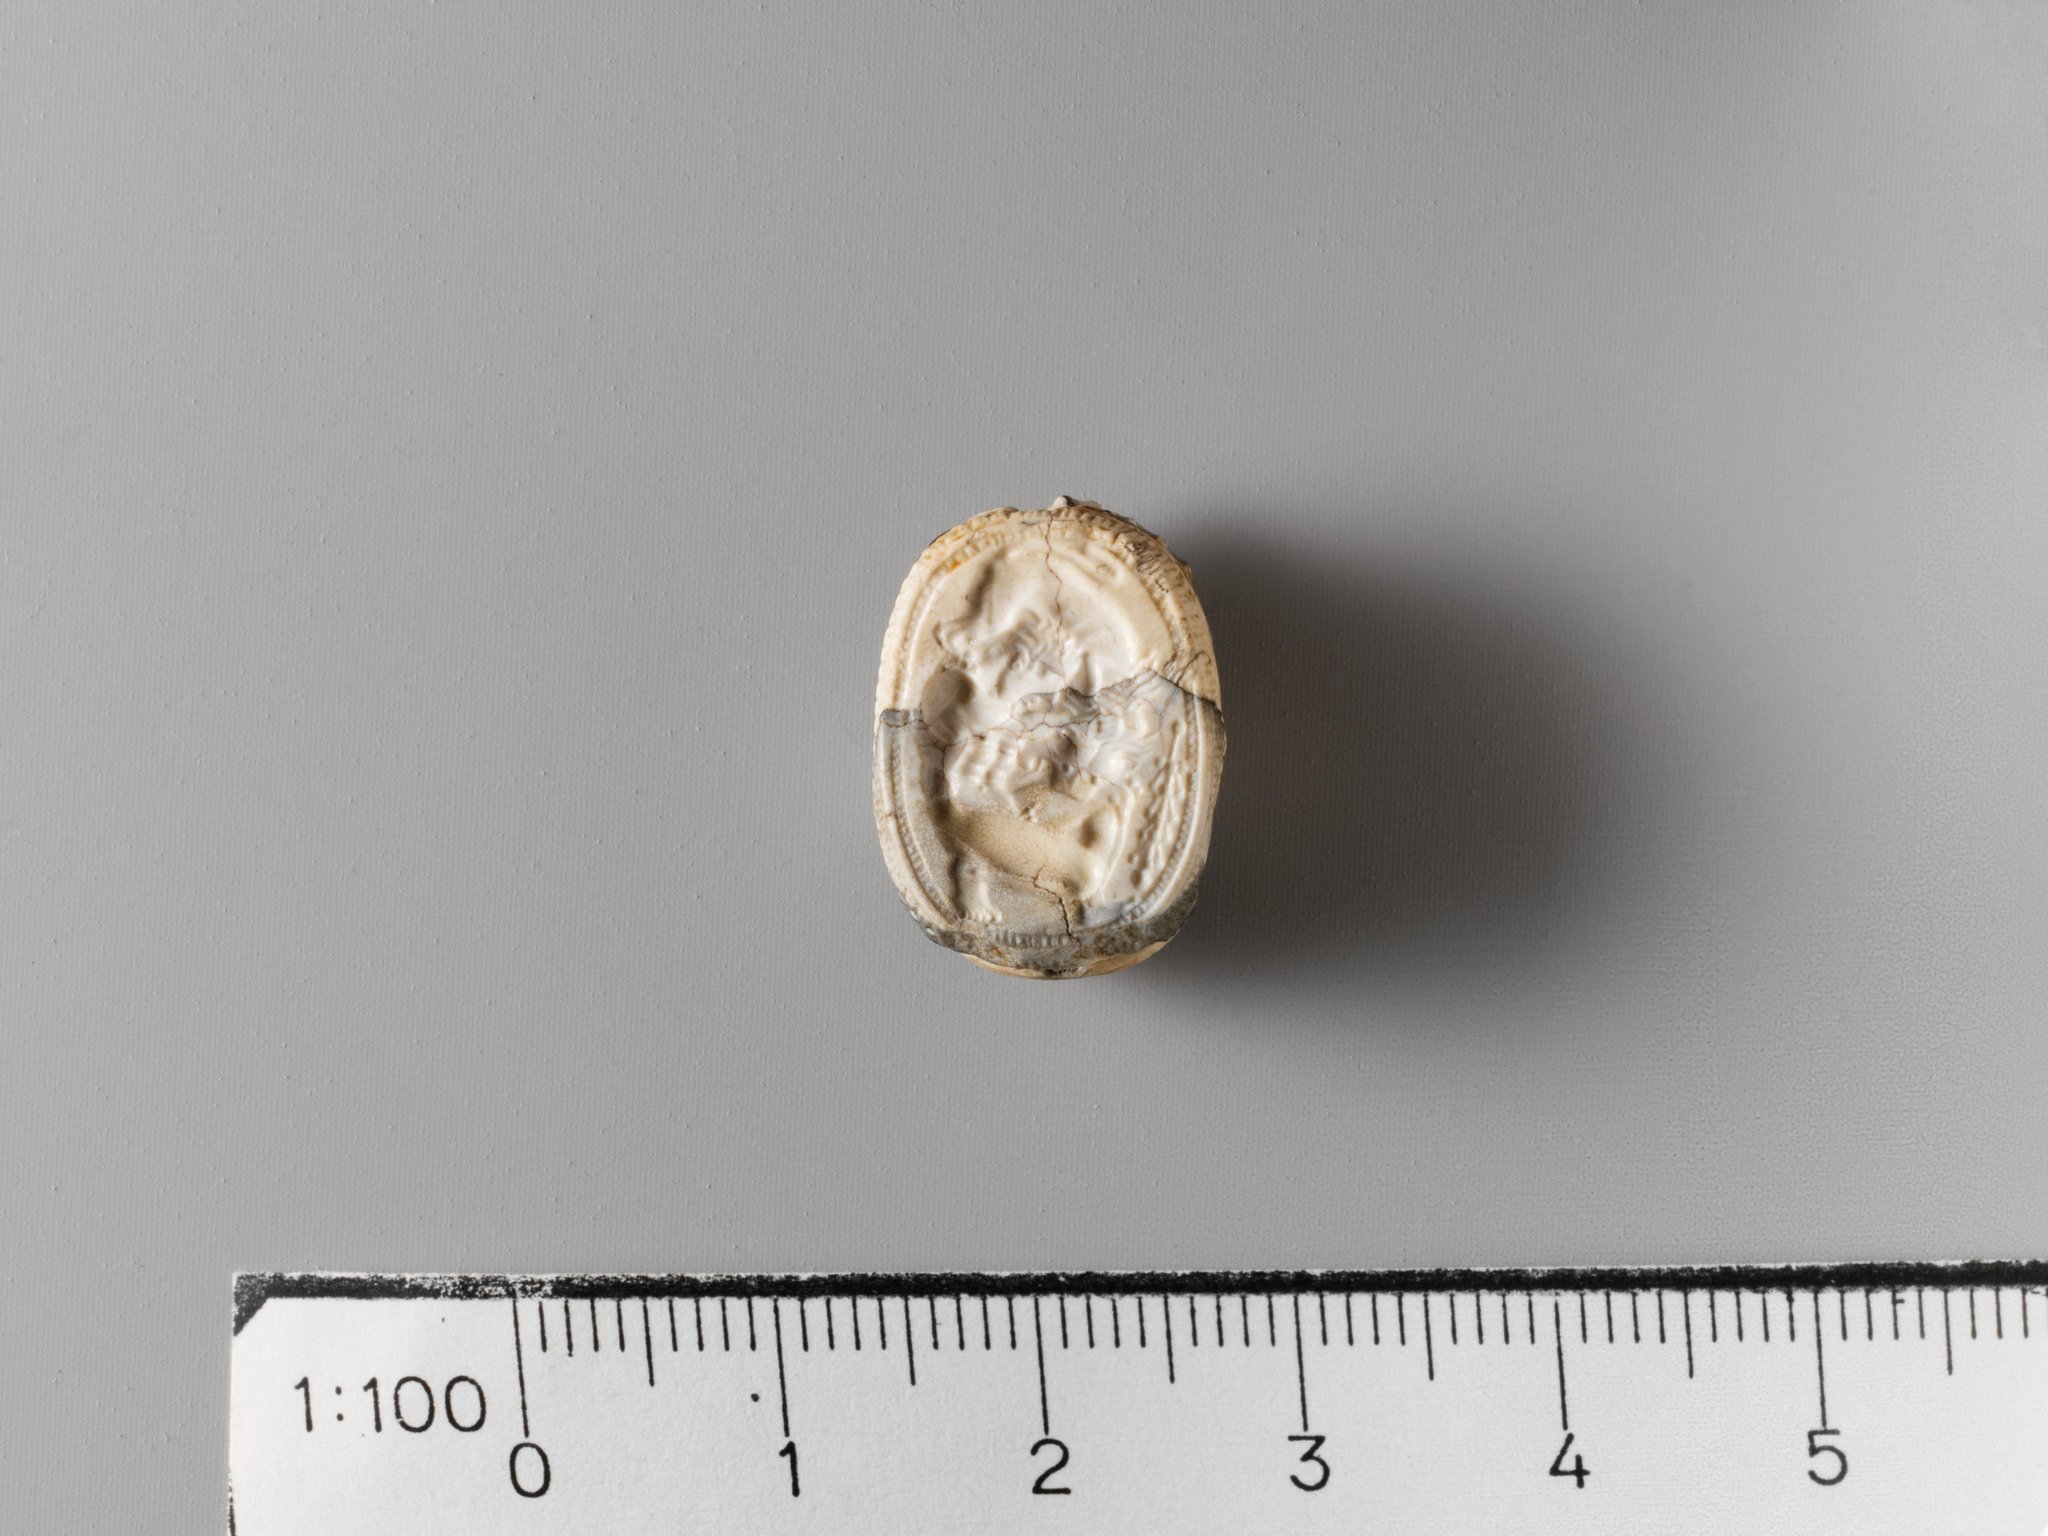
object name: scarab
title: Banded agate scarab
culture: etruscan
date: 434-301 BCE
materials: stone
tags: scarabs